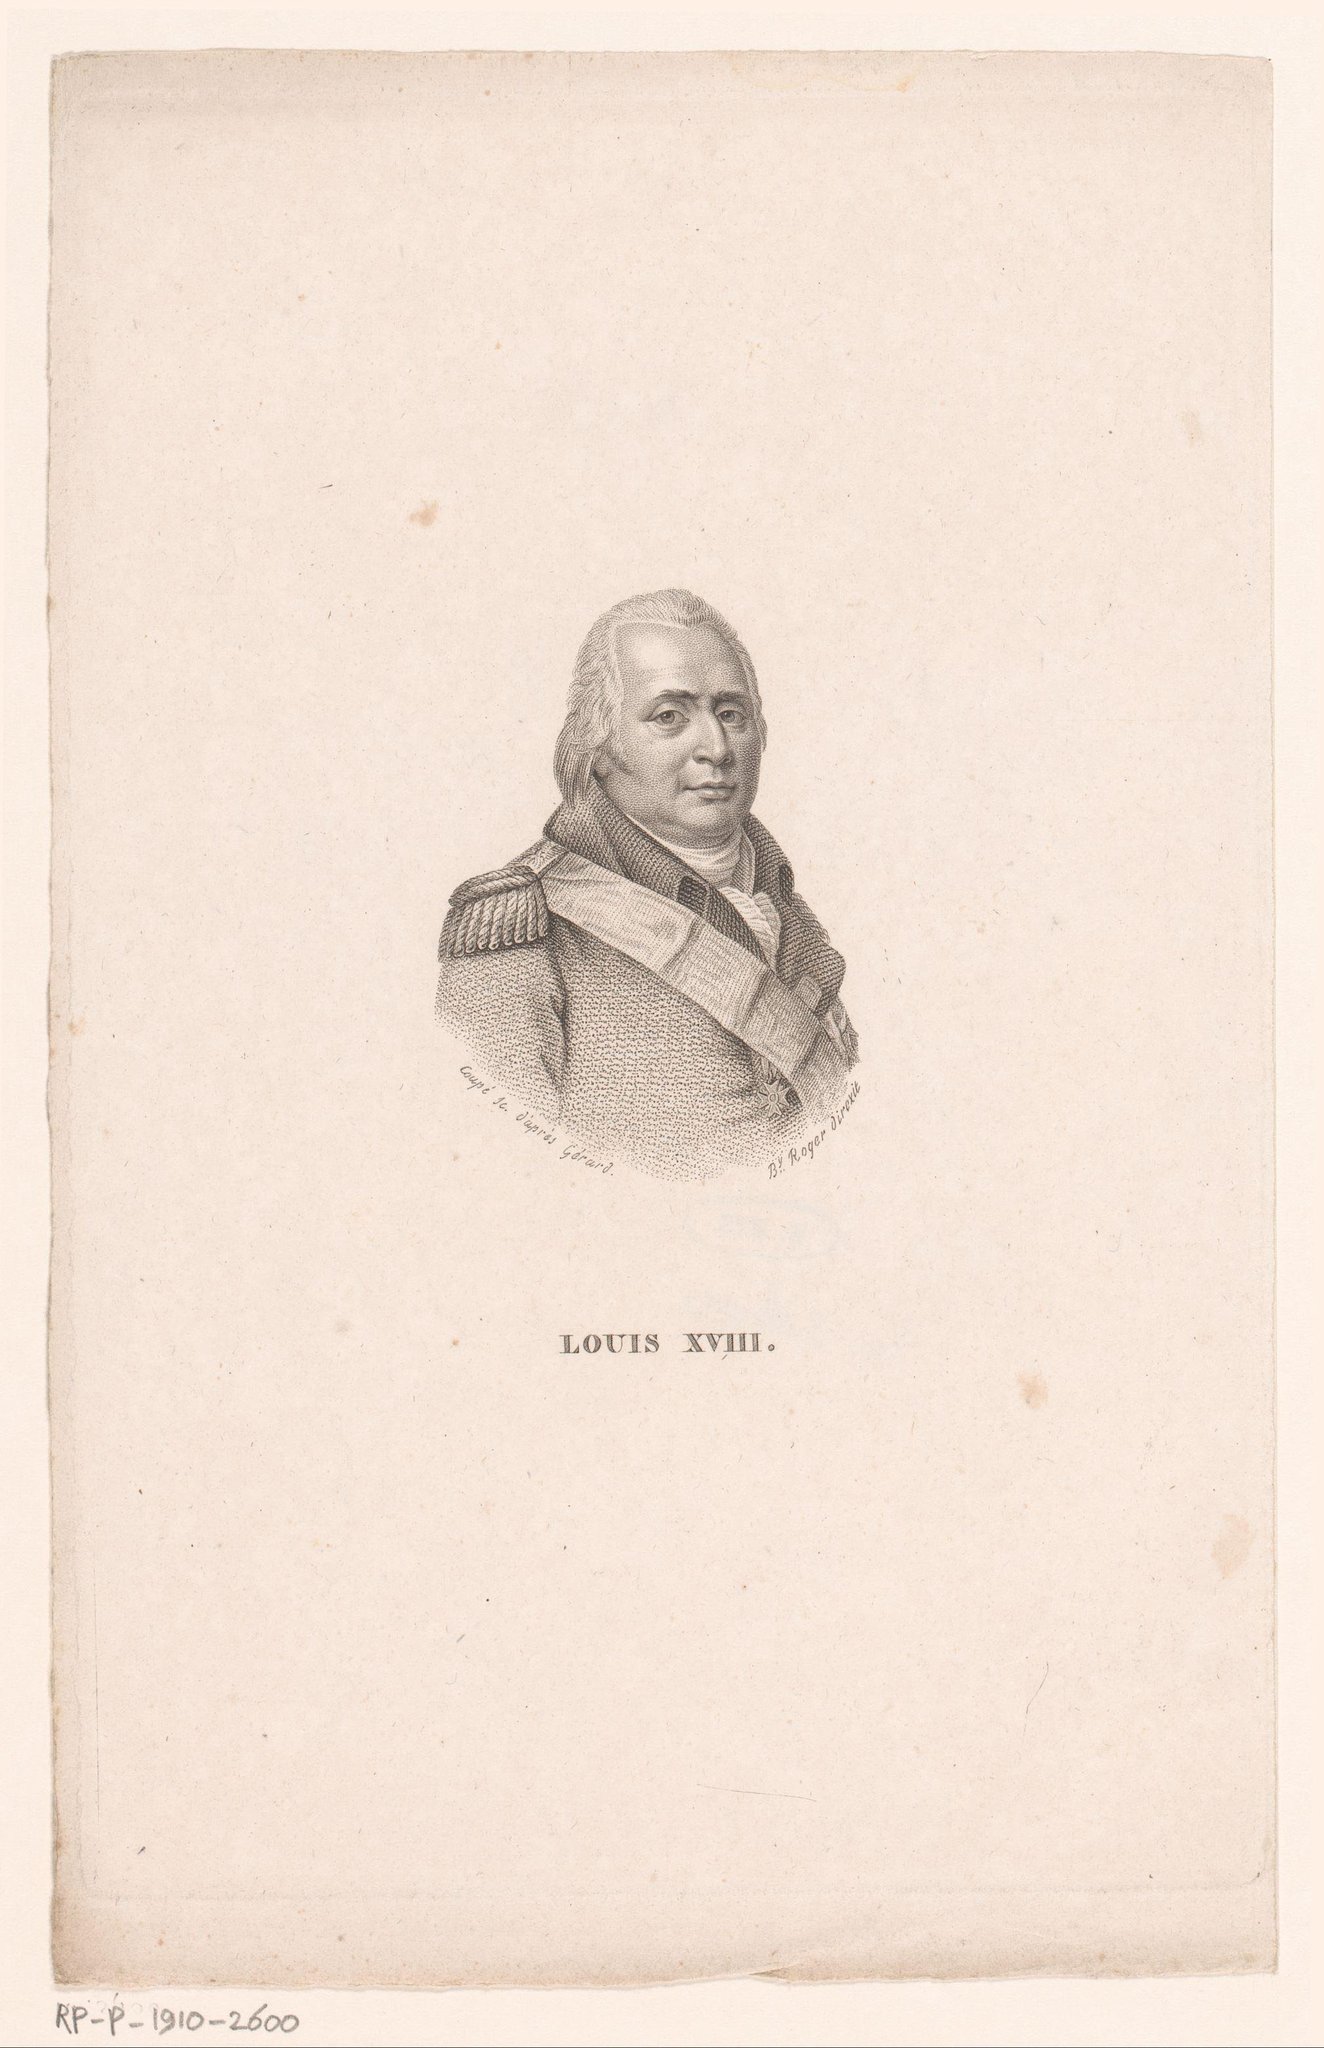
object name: print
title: Portret van Lodewijk XVIII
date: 1794-1846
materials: paper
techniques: engraving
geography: france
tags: paris, lodewijk xviii (koning van frankrijk), historical persons, king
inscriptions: collector's mark: Lugt 2228